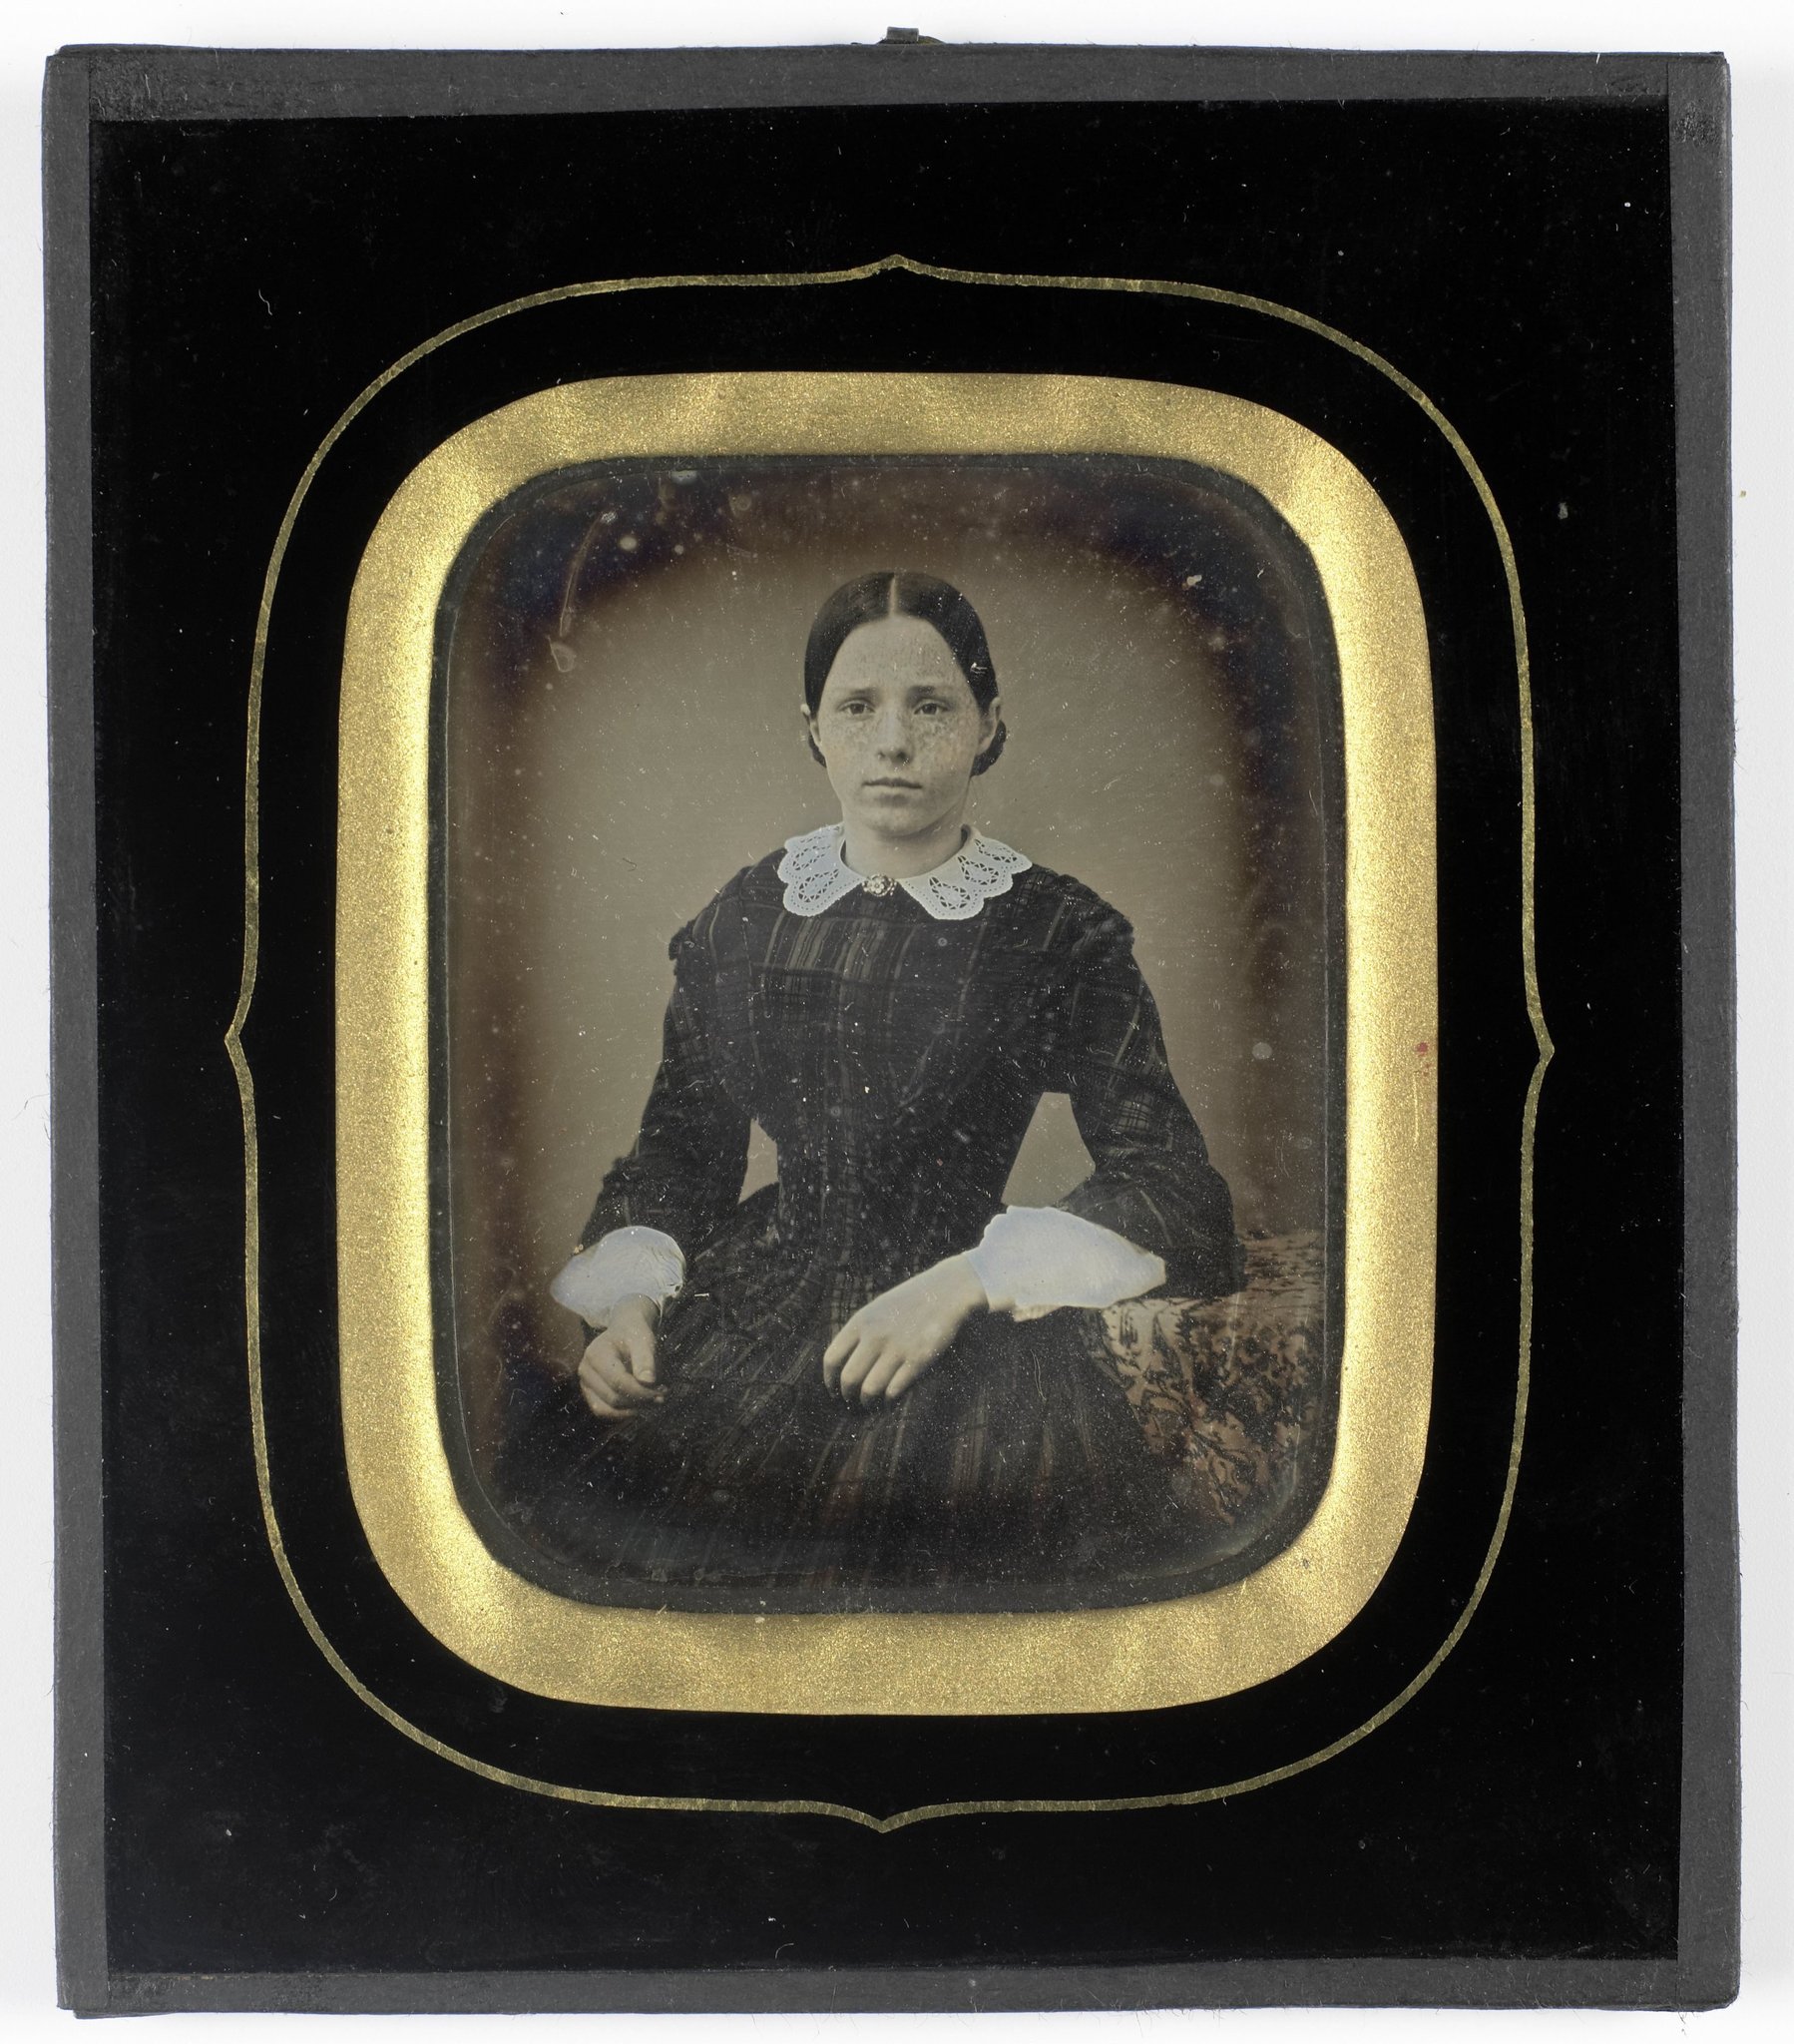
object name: photograph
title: Portret van een onbekende jonge vrouw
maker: Anonymous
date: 1840-1860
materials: copper, glass, paper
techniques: daguerreotype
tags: adolescent, young woman, maiden, historical persons